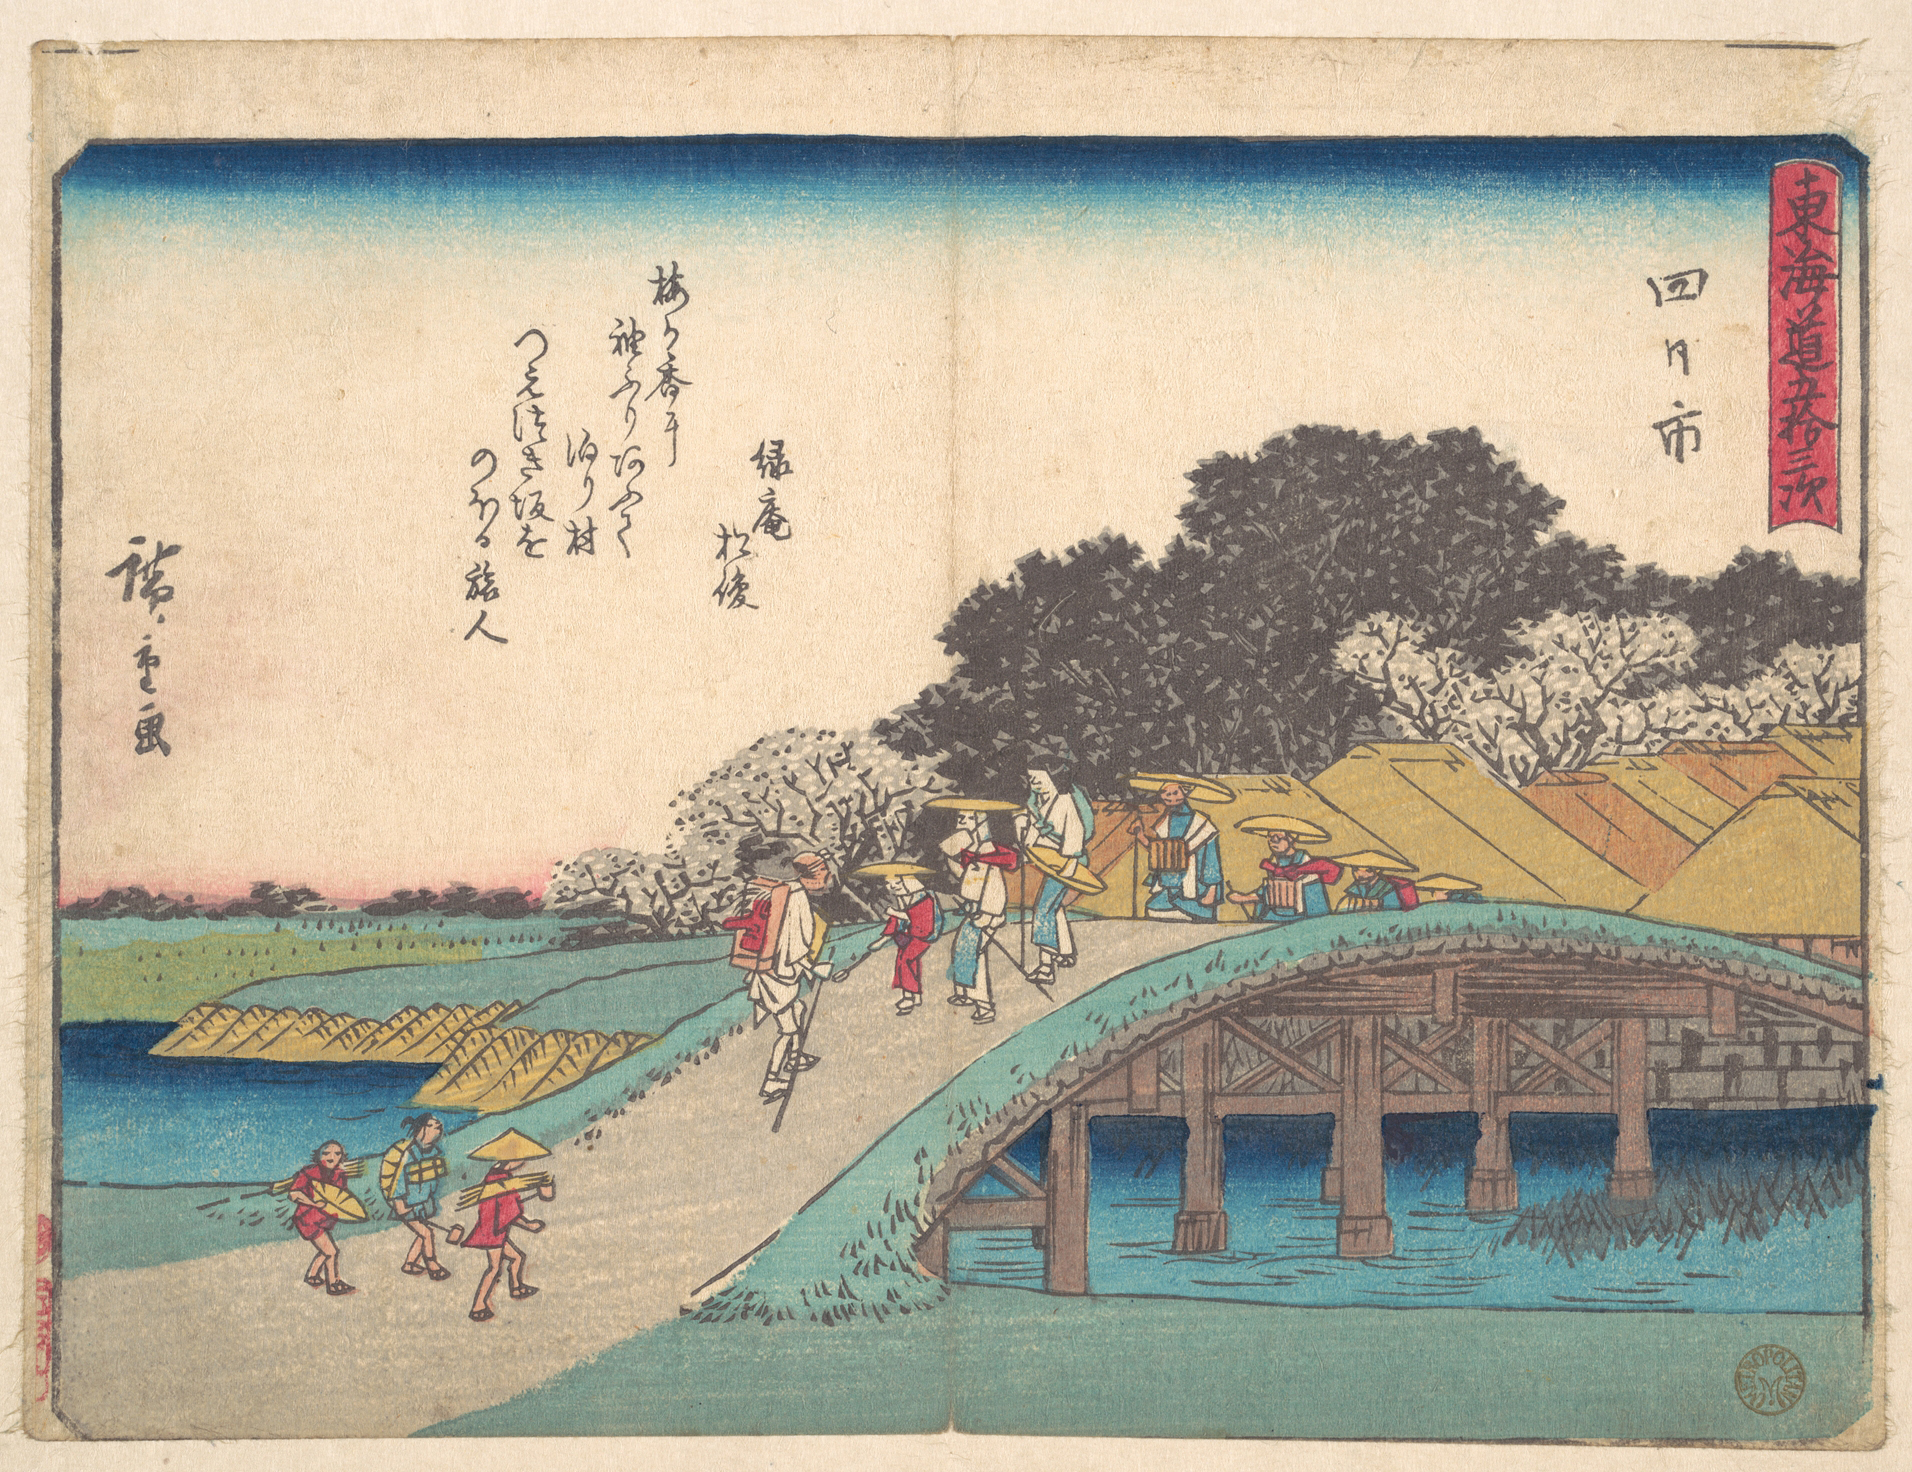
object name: print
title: Yokkaichi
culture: japanese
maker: utagawa hiroshige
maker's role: artist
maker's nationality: japanese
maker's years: 1797-1858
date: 1838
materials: ink, paper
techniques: woodblock print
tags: human figures,bridges